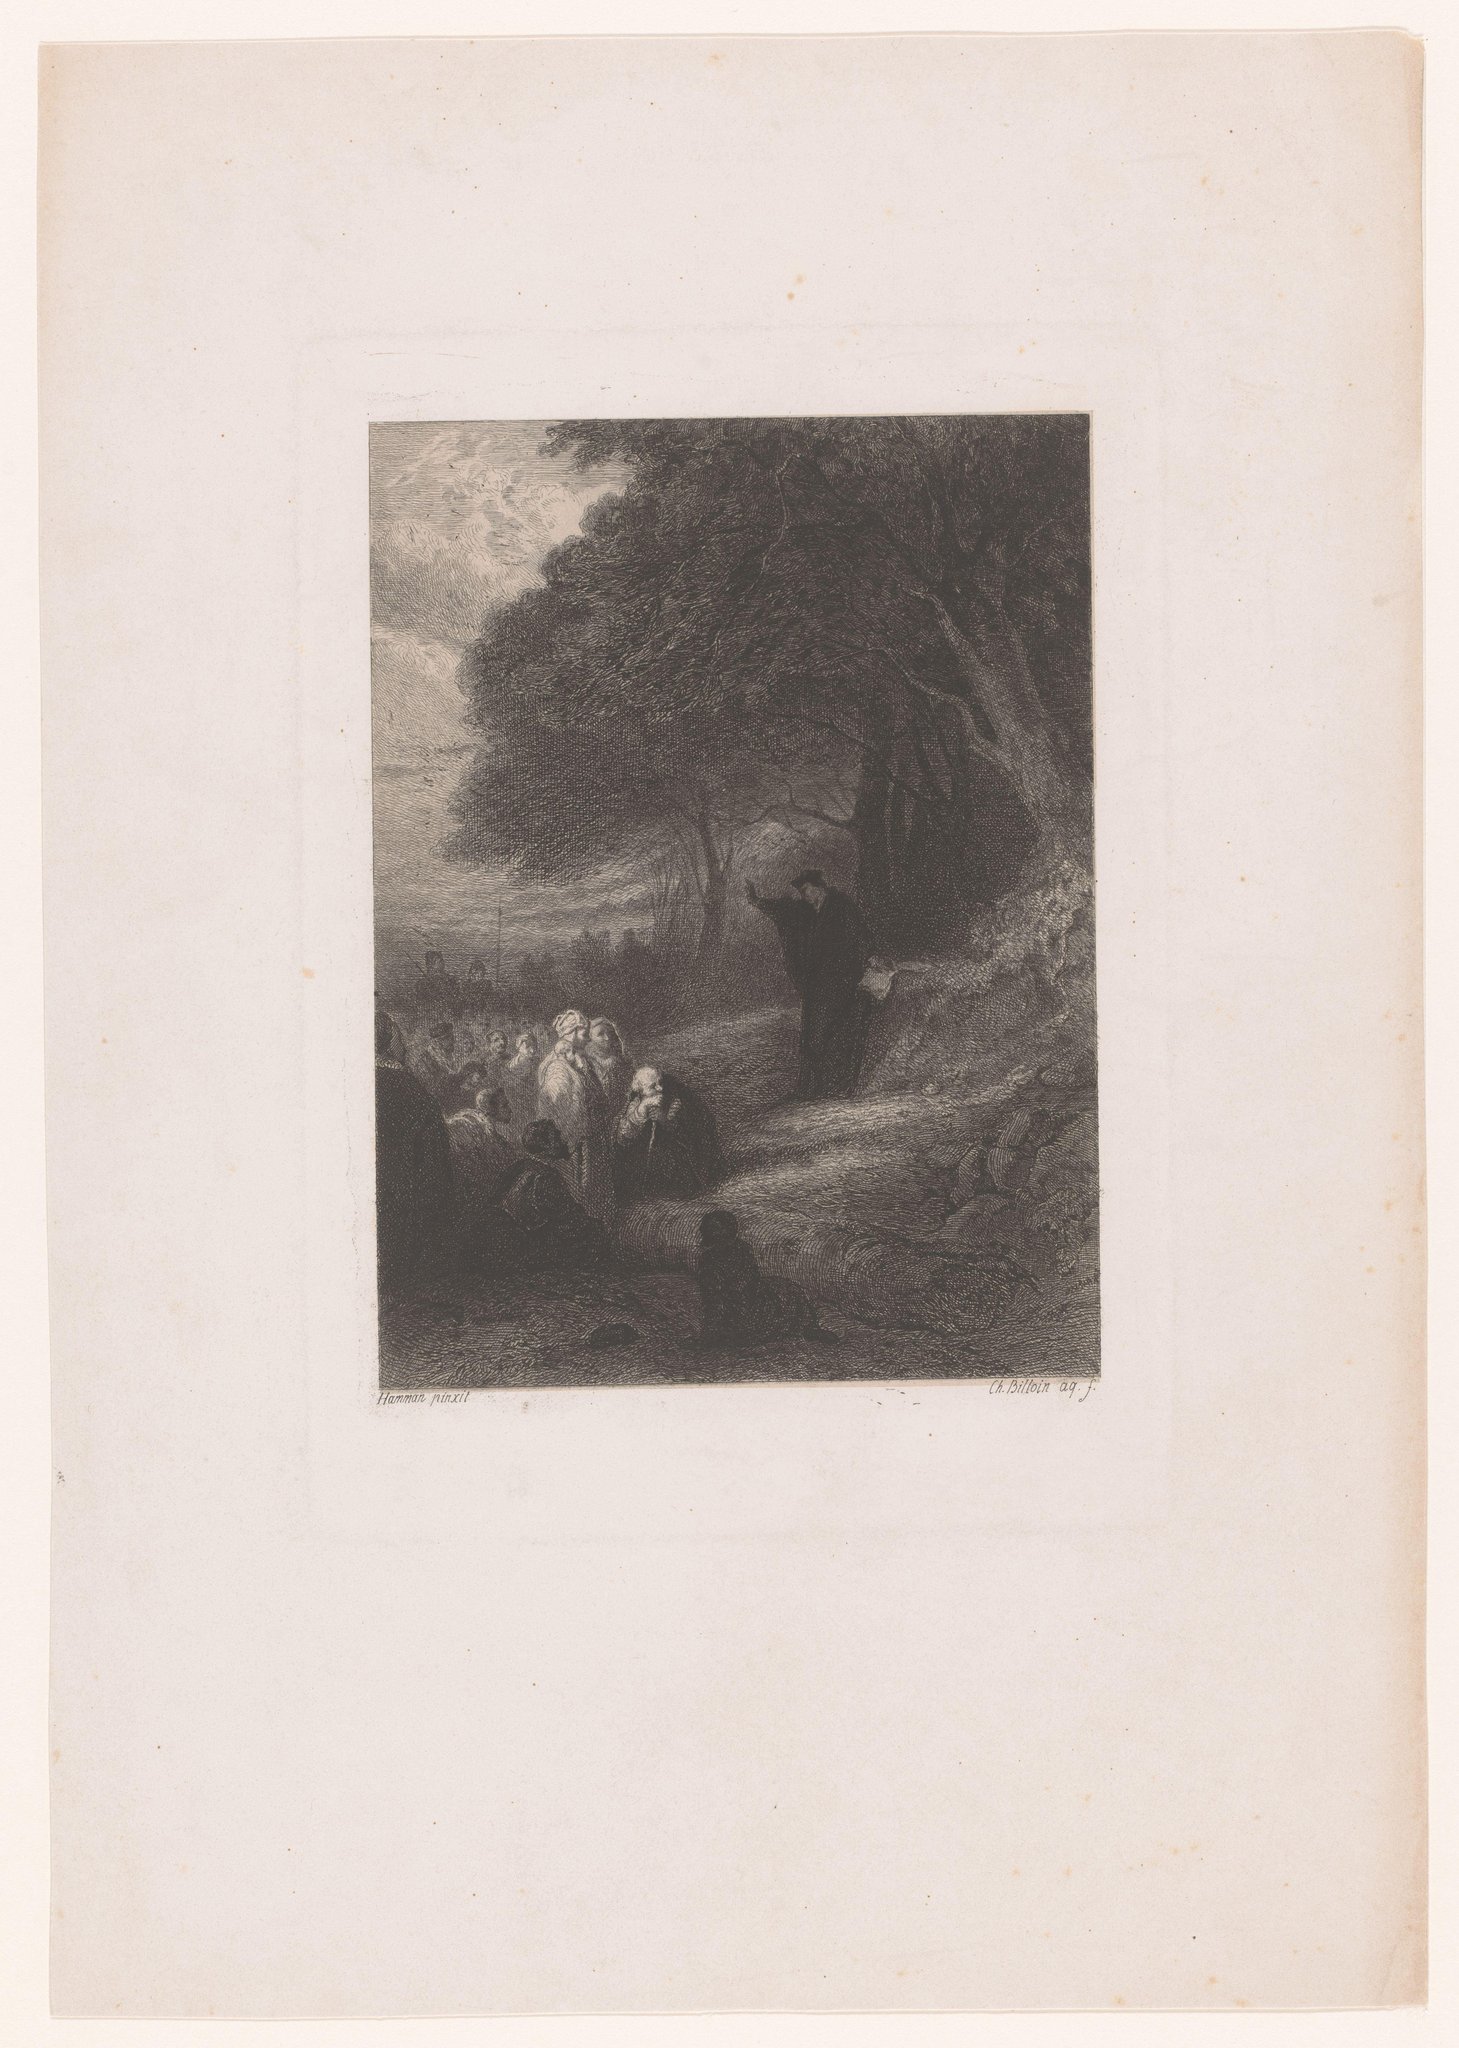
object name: print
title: Hagenpreek van de Hugenoten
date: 1850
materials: paper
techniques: etching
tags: protestant service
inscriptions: collector's mark: Lugt 2228